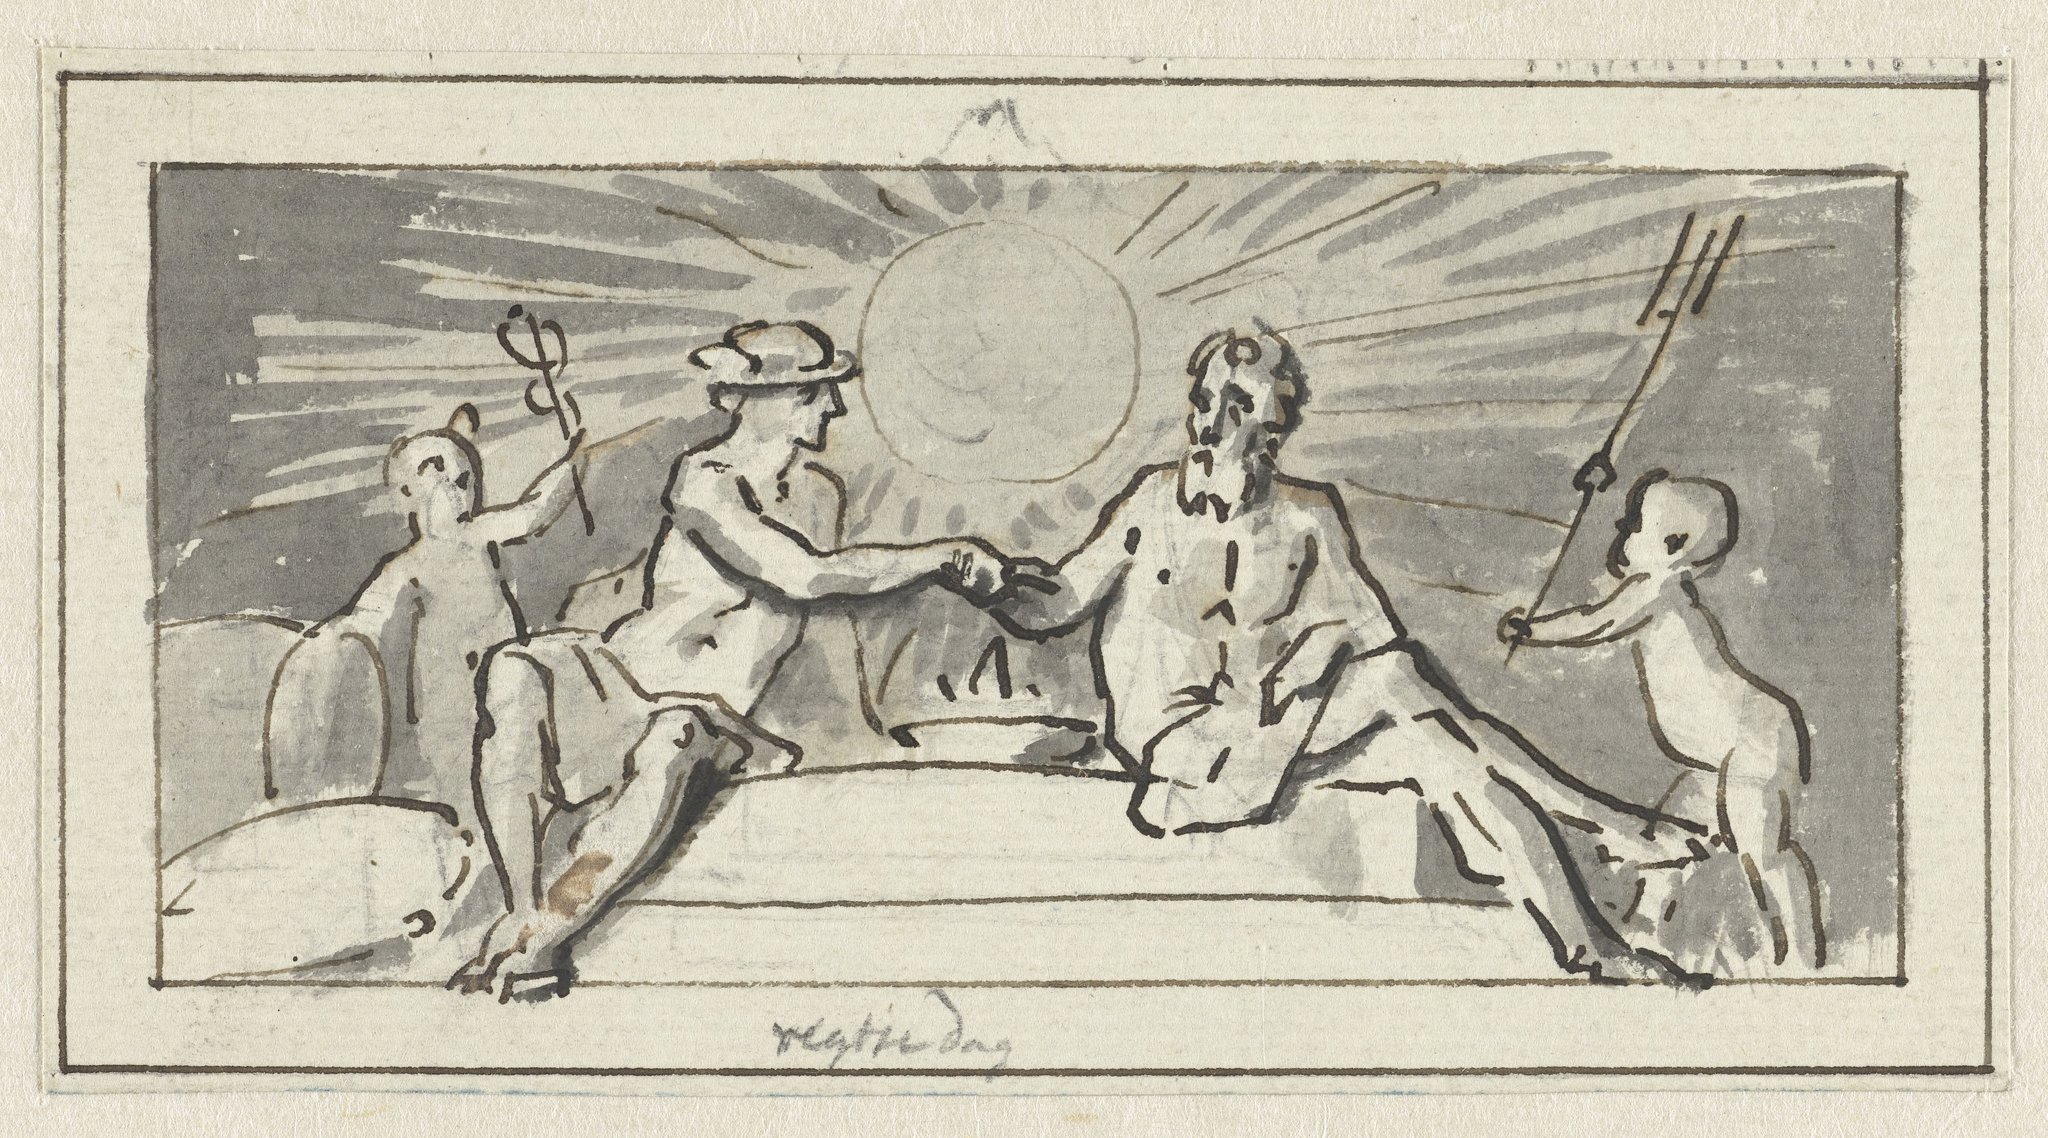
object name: drawing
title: Allegorie op 't verbond van Zeevaart en Koophandel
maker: jurriaan andriessen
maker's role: draughtsman, painter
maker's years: 1742-1819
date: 1752-1819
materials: graphite, ink, paper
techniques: brush, pen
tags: (story of) neptune (poseidon), (story of) mercury (hermes), allegory of trade; 'commertio della vita humana' (ripa), 'navigatione' (ripa)